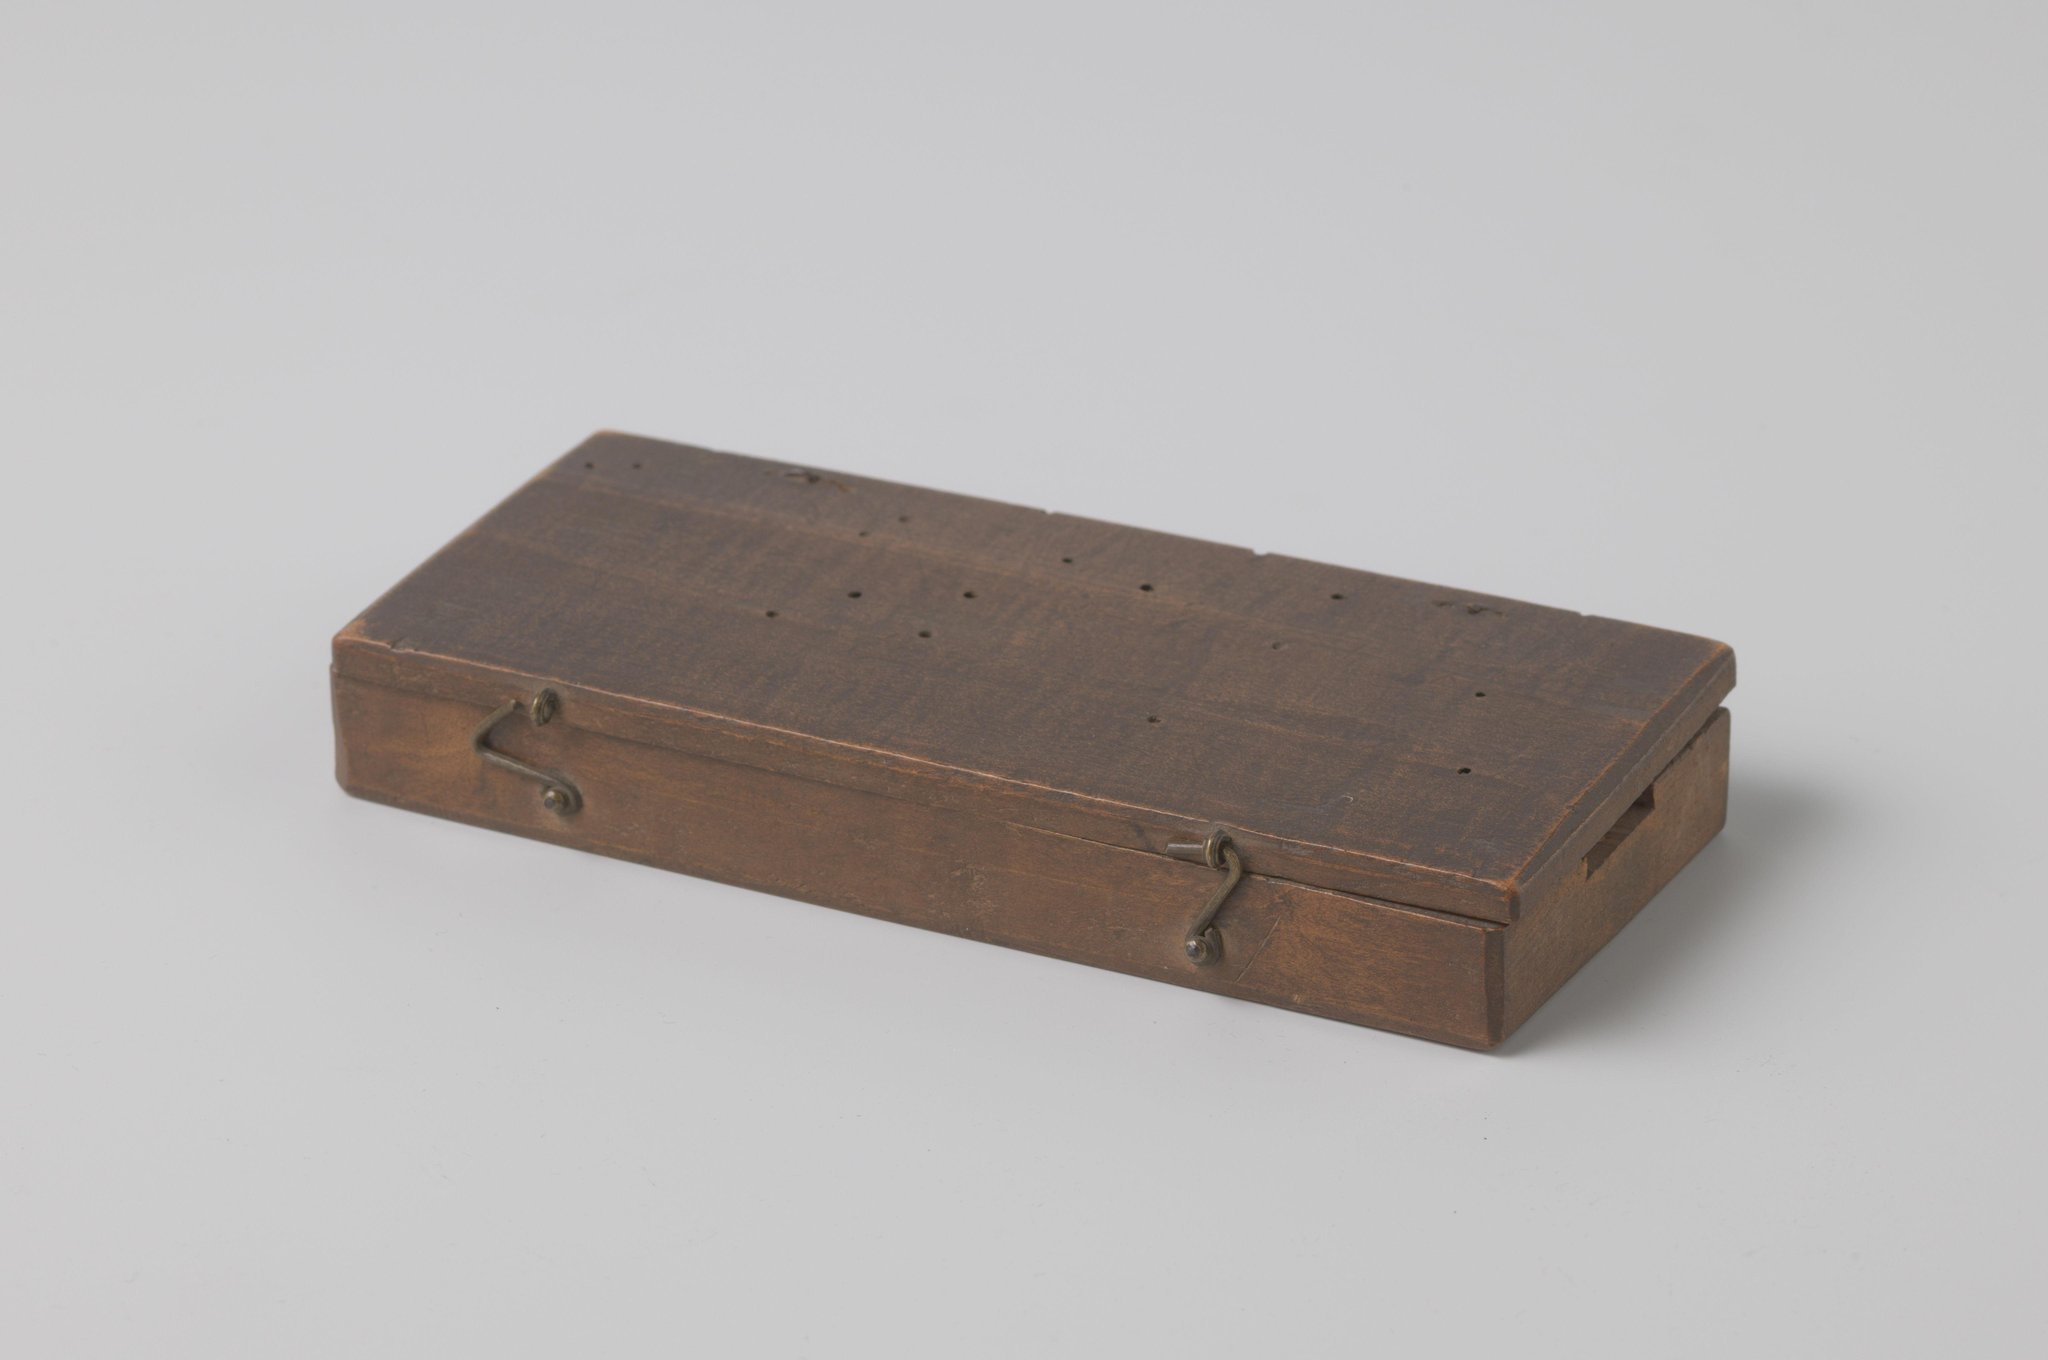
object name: coin weight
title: Muntgewichtdoos met muntgewichten en balans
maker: Anonymous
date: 1600-1800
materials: metal, paper, silk, wood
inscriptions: inscription: ‘Recht abprobirt V : J P’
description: Muntgewichtjes en balans in doosje van hout. Het doosje is bestemd voor acht gewichtjes. Hiervan ontbreken er zes. Op het dekseltje staat een merk: recht abprobirt V : J P